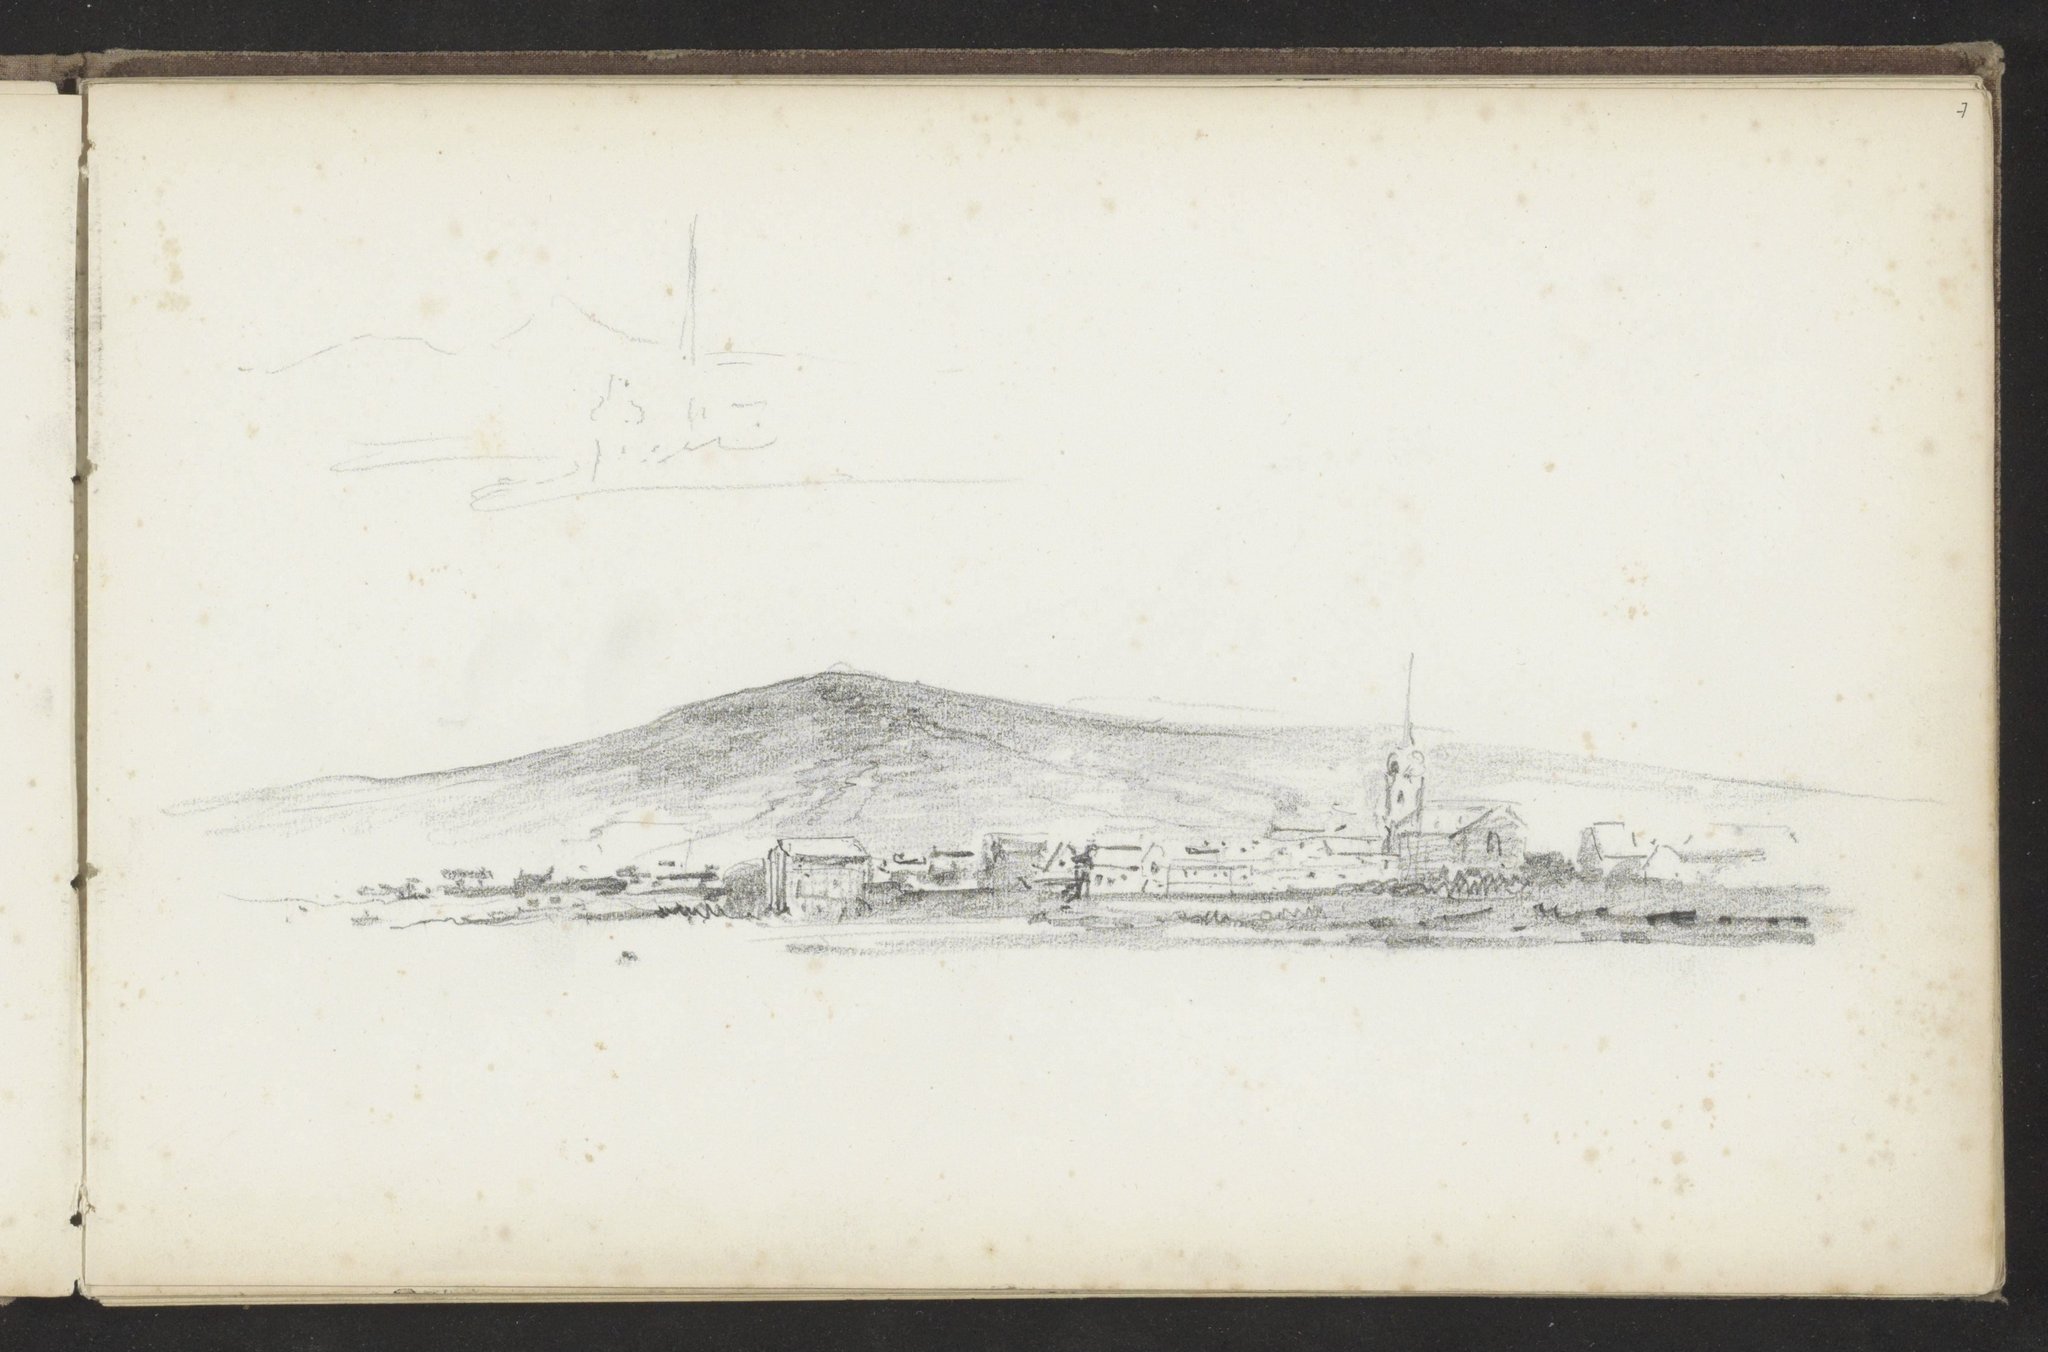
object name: sketchbook leaf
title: Stad aan de voet van een berg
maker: maria vos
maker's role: draughtsman, painter, print maker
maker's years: 1824-1906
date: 1860-1865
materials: paper, pencil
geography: rhine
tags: city-view, and landscape with man-made constructions, mountains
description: Vermoedelijk een stad aan de Rijn. Blad 7 recto uit een schetsboek met 55 bladen.